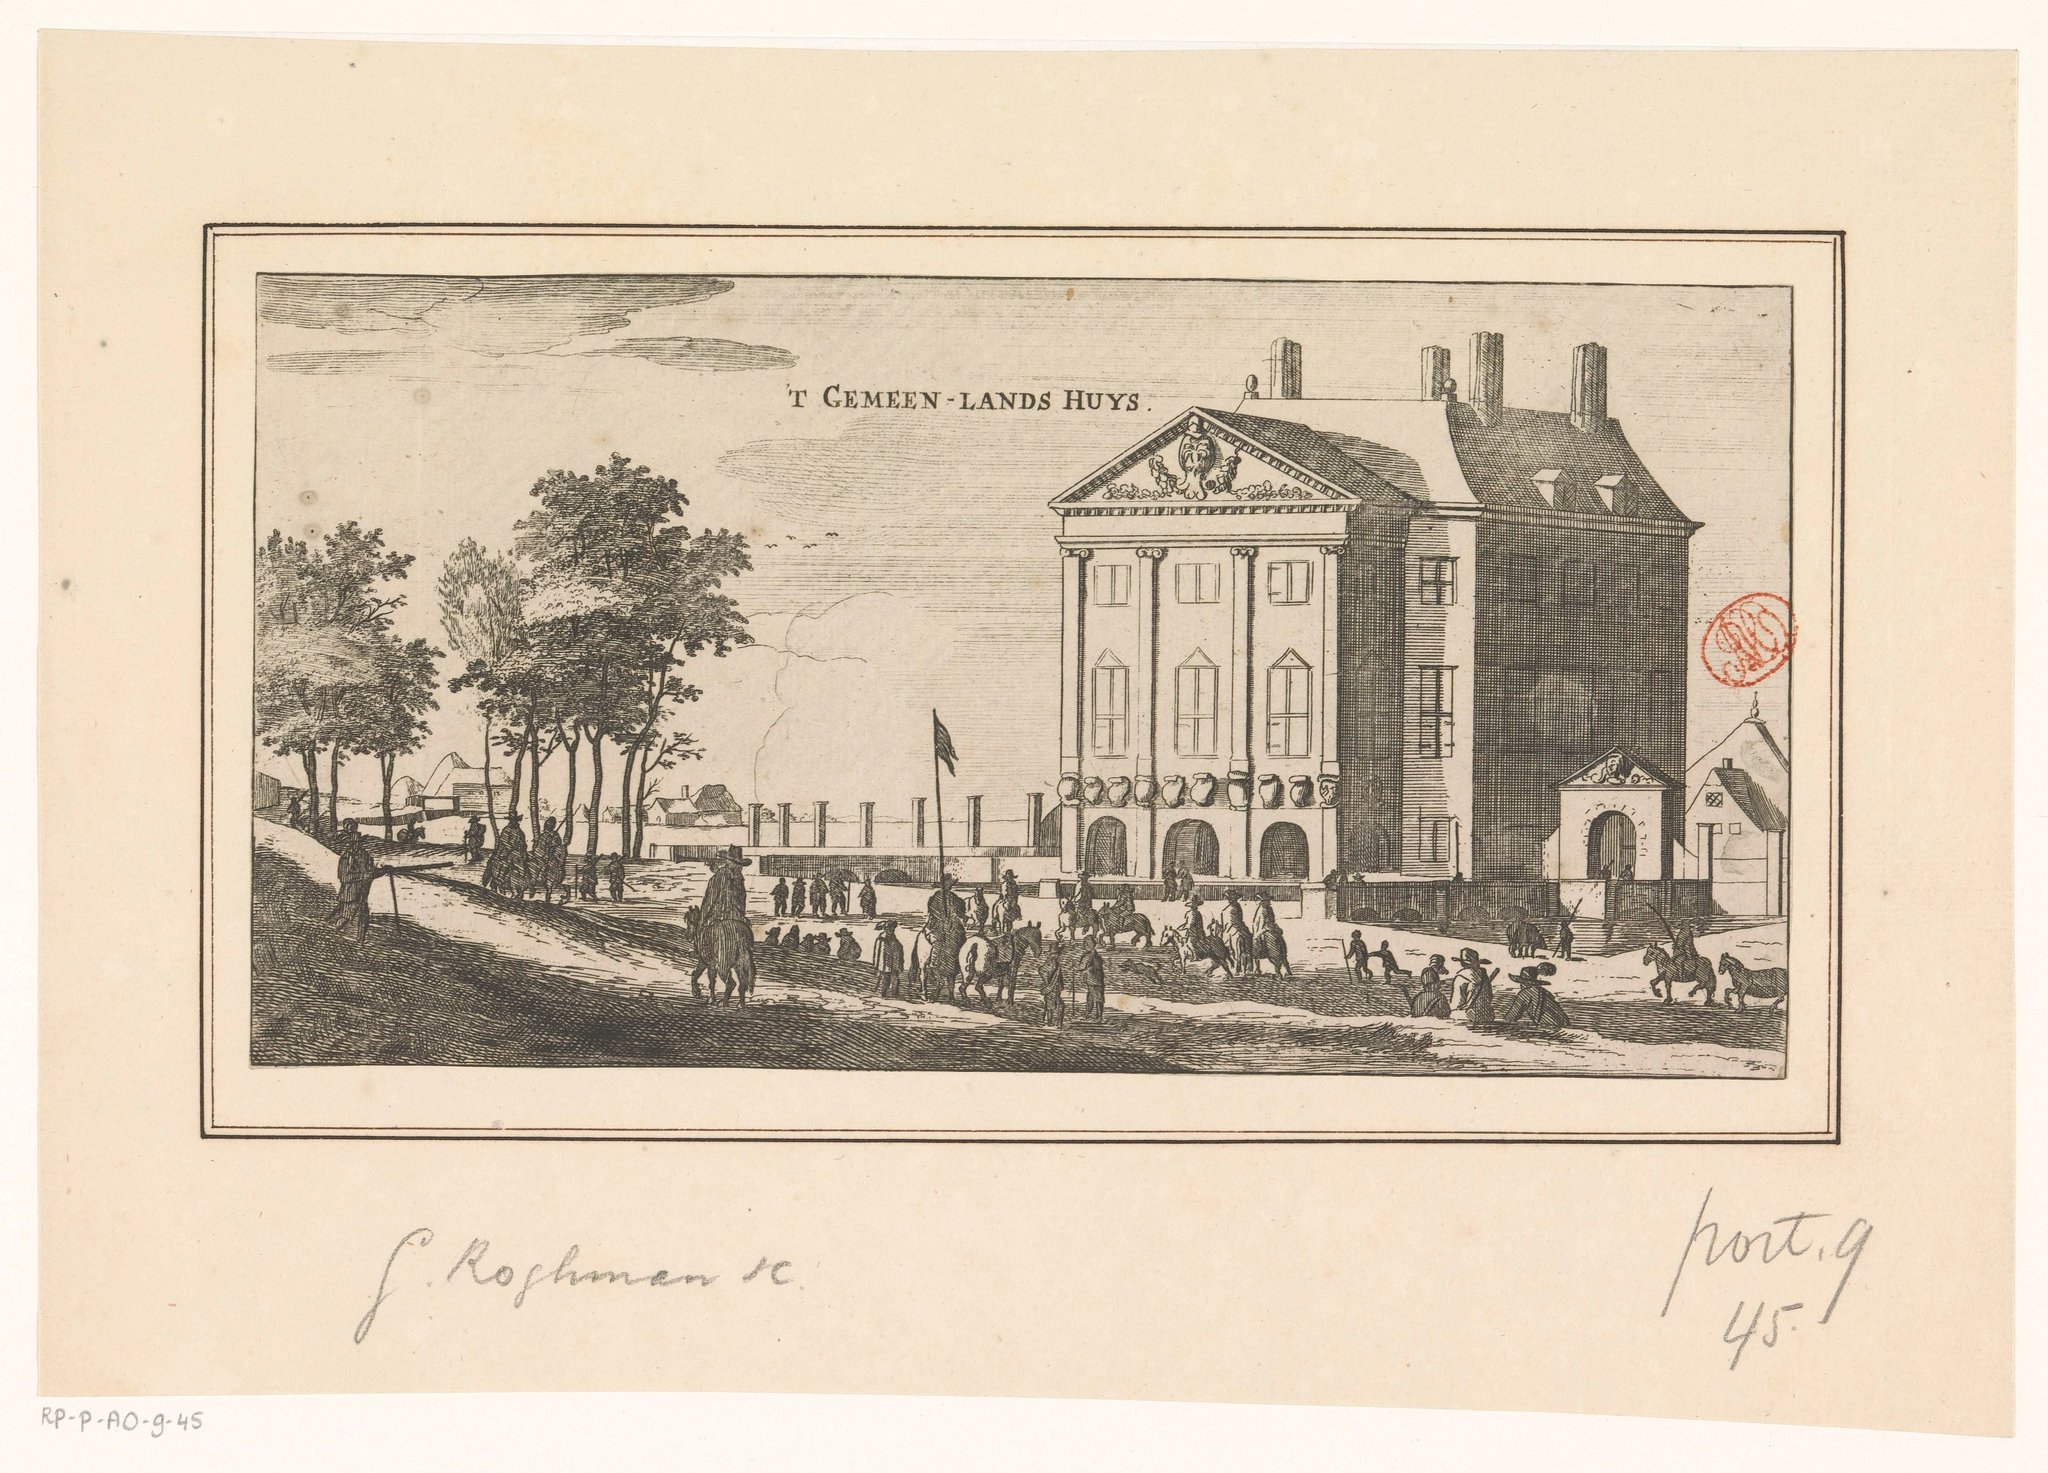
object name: print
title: Gemeenlandshuis van Rijnland te Halfweg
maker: Anonymous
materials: paper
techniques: engraving, etching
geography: northern netherlands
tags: william ii (prince of orange)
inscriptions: collector's mark: Lugt 195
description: Gezicht op Huis Zwanenburg, het gemeenlandshuis van het hoogheemraadschap van Rijnland te Halfweg. Onderdeel van een serie van zes gezichten in de dorpen waar de troepen van prins Willem II ingekwartierd lagen tijdens het beleg van Amsterdam, van 30 juli tot 4 augustus 1650.